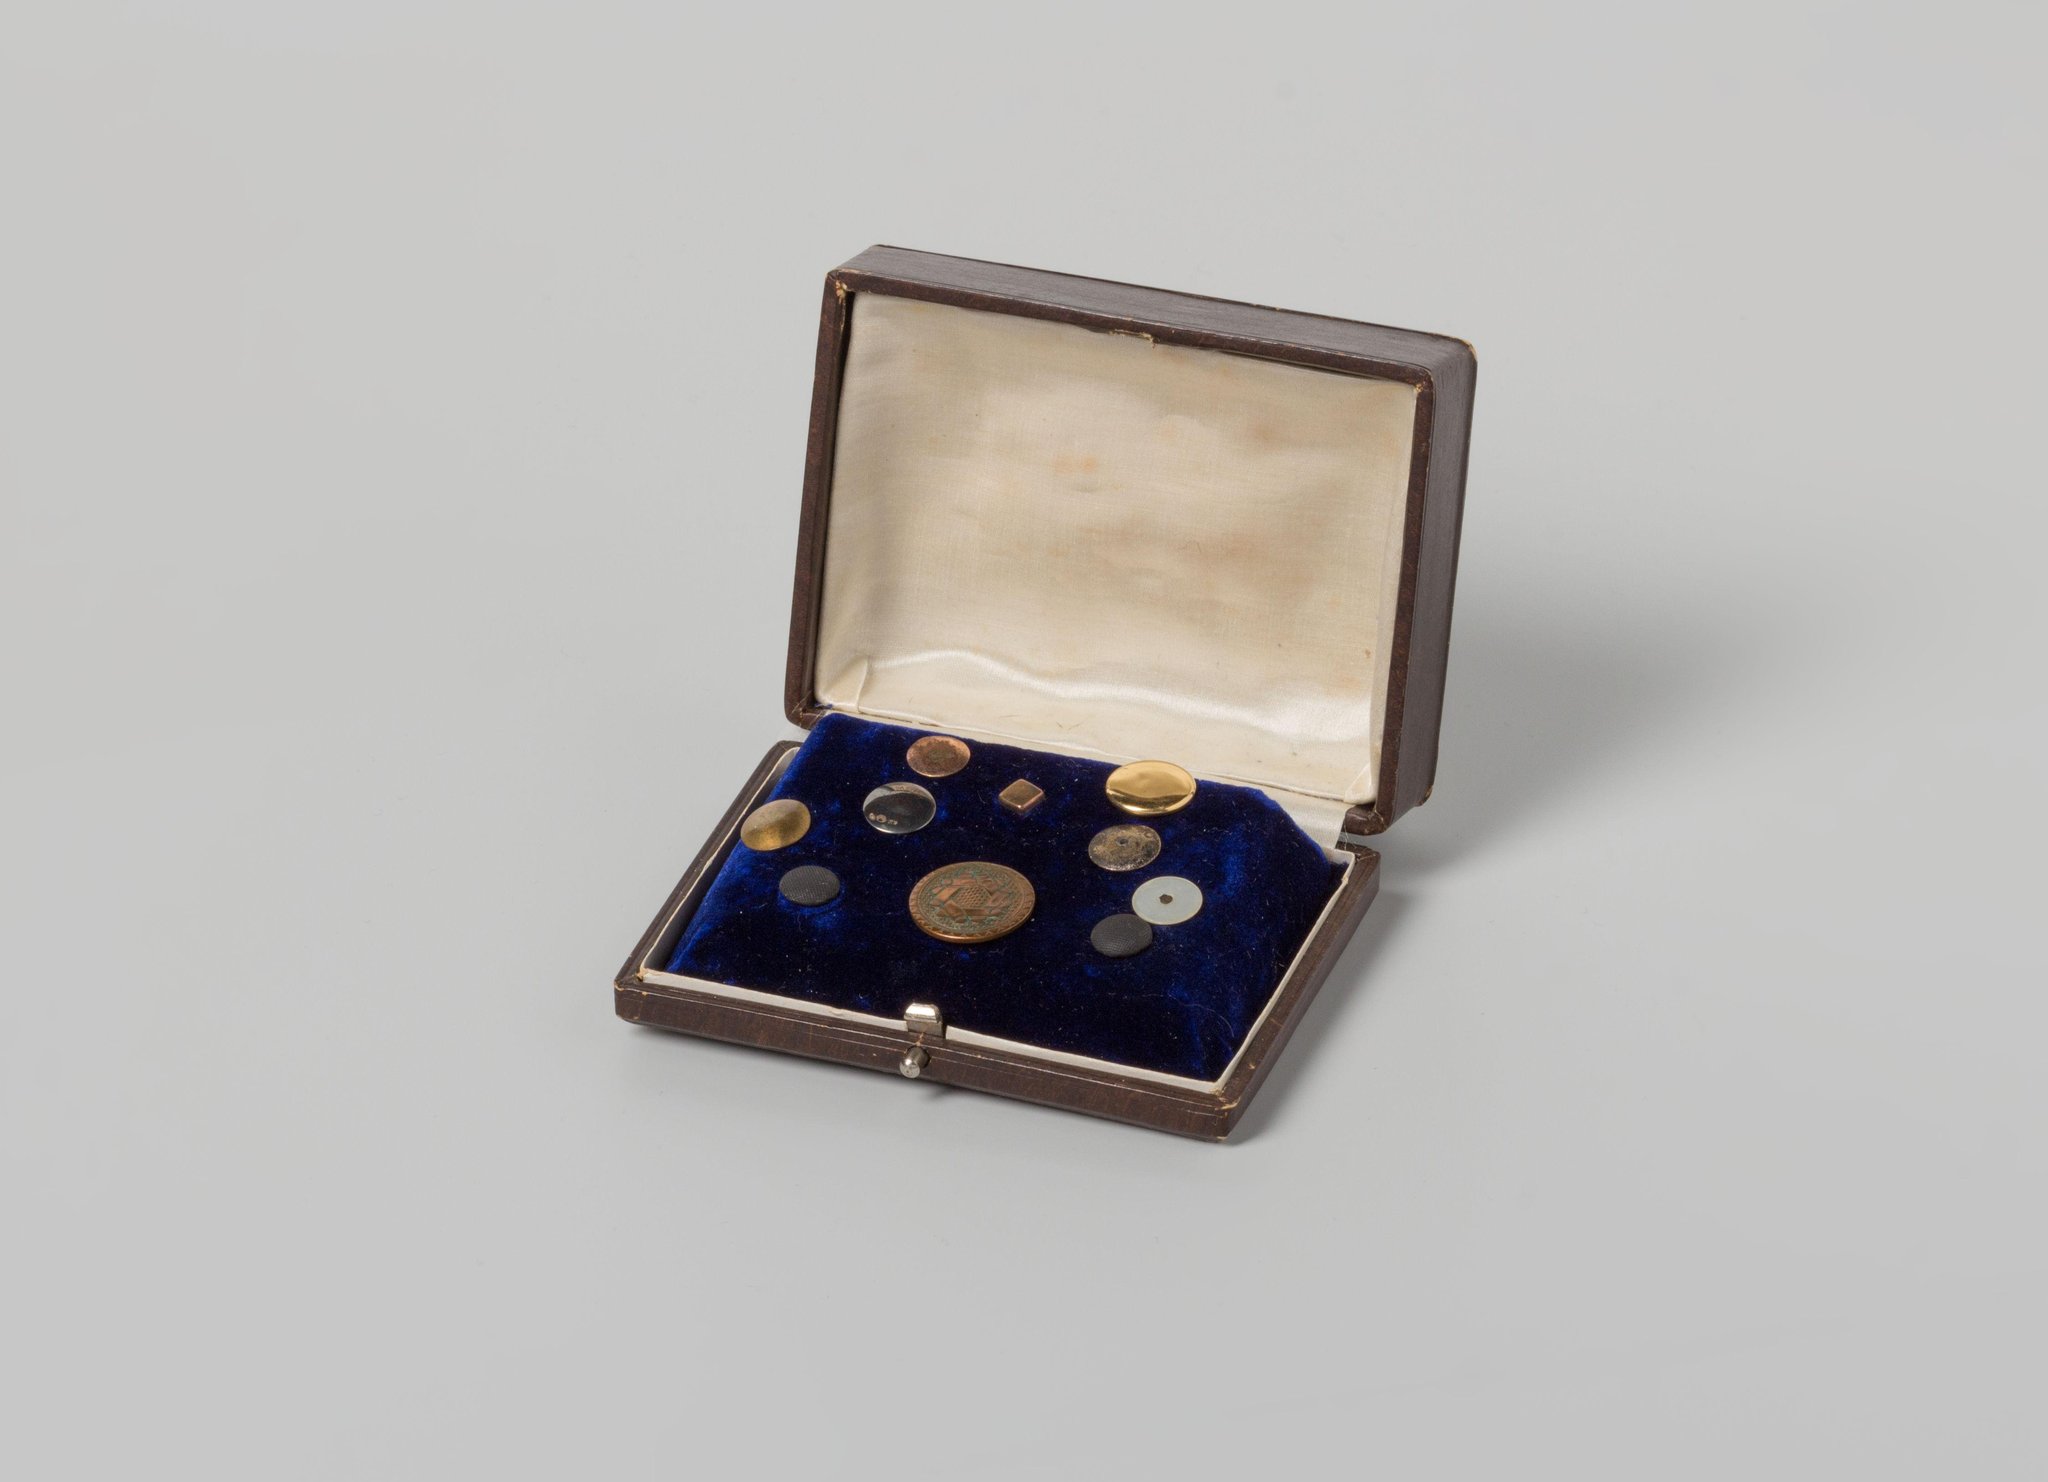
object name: box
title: Met donkerbruin leer beklede doos, van binnen bekleed met wit satijn; de gewelfde bodem is bekleed met blauw fluweel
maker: Anonymous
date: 1900-1925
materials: leather, textile, velvet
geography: western europe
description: Met donkerbruin leer beklede doos, van binnen bekleed met wit satijn; de gewelfde bodem is bekleed met blauw fluweel